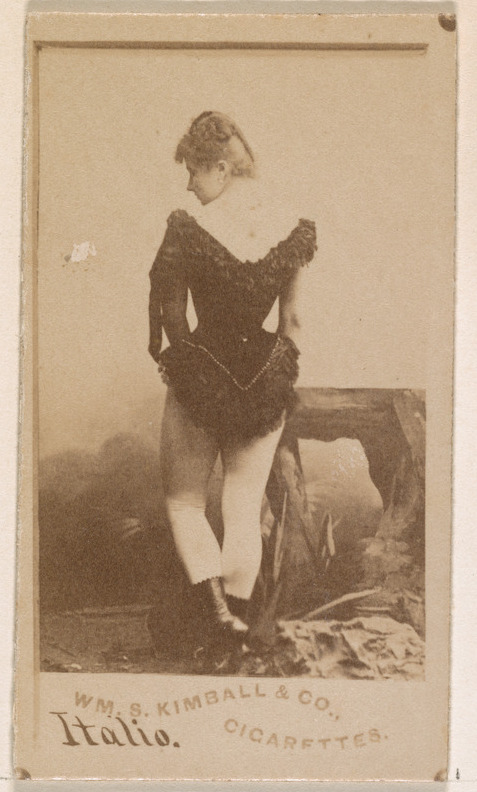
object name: photograph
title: Miss Italio, from the Actresses series (N203) issued by Wm. S. Kimball & Co.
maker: william s. kimball & company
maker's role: publisher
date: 1889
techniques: color lithograph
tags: profiles,women,actresses